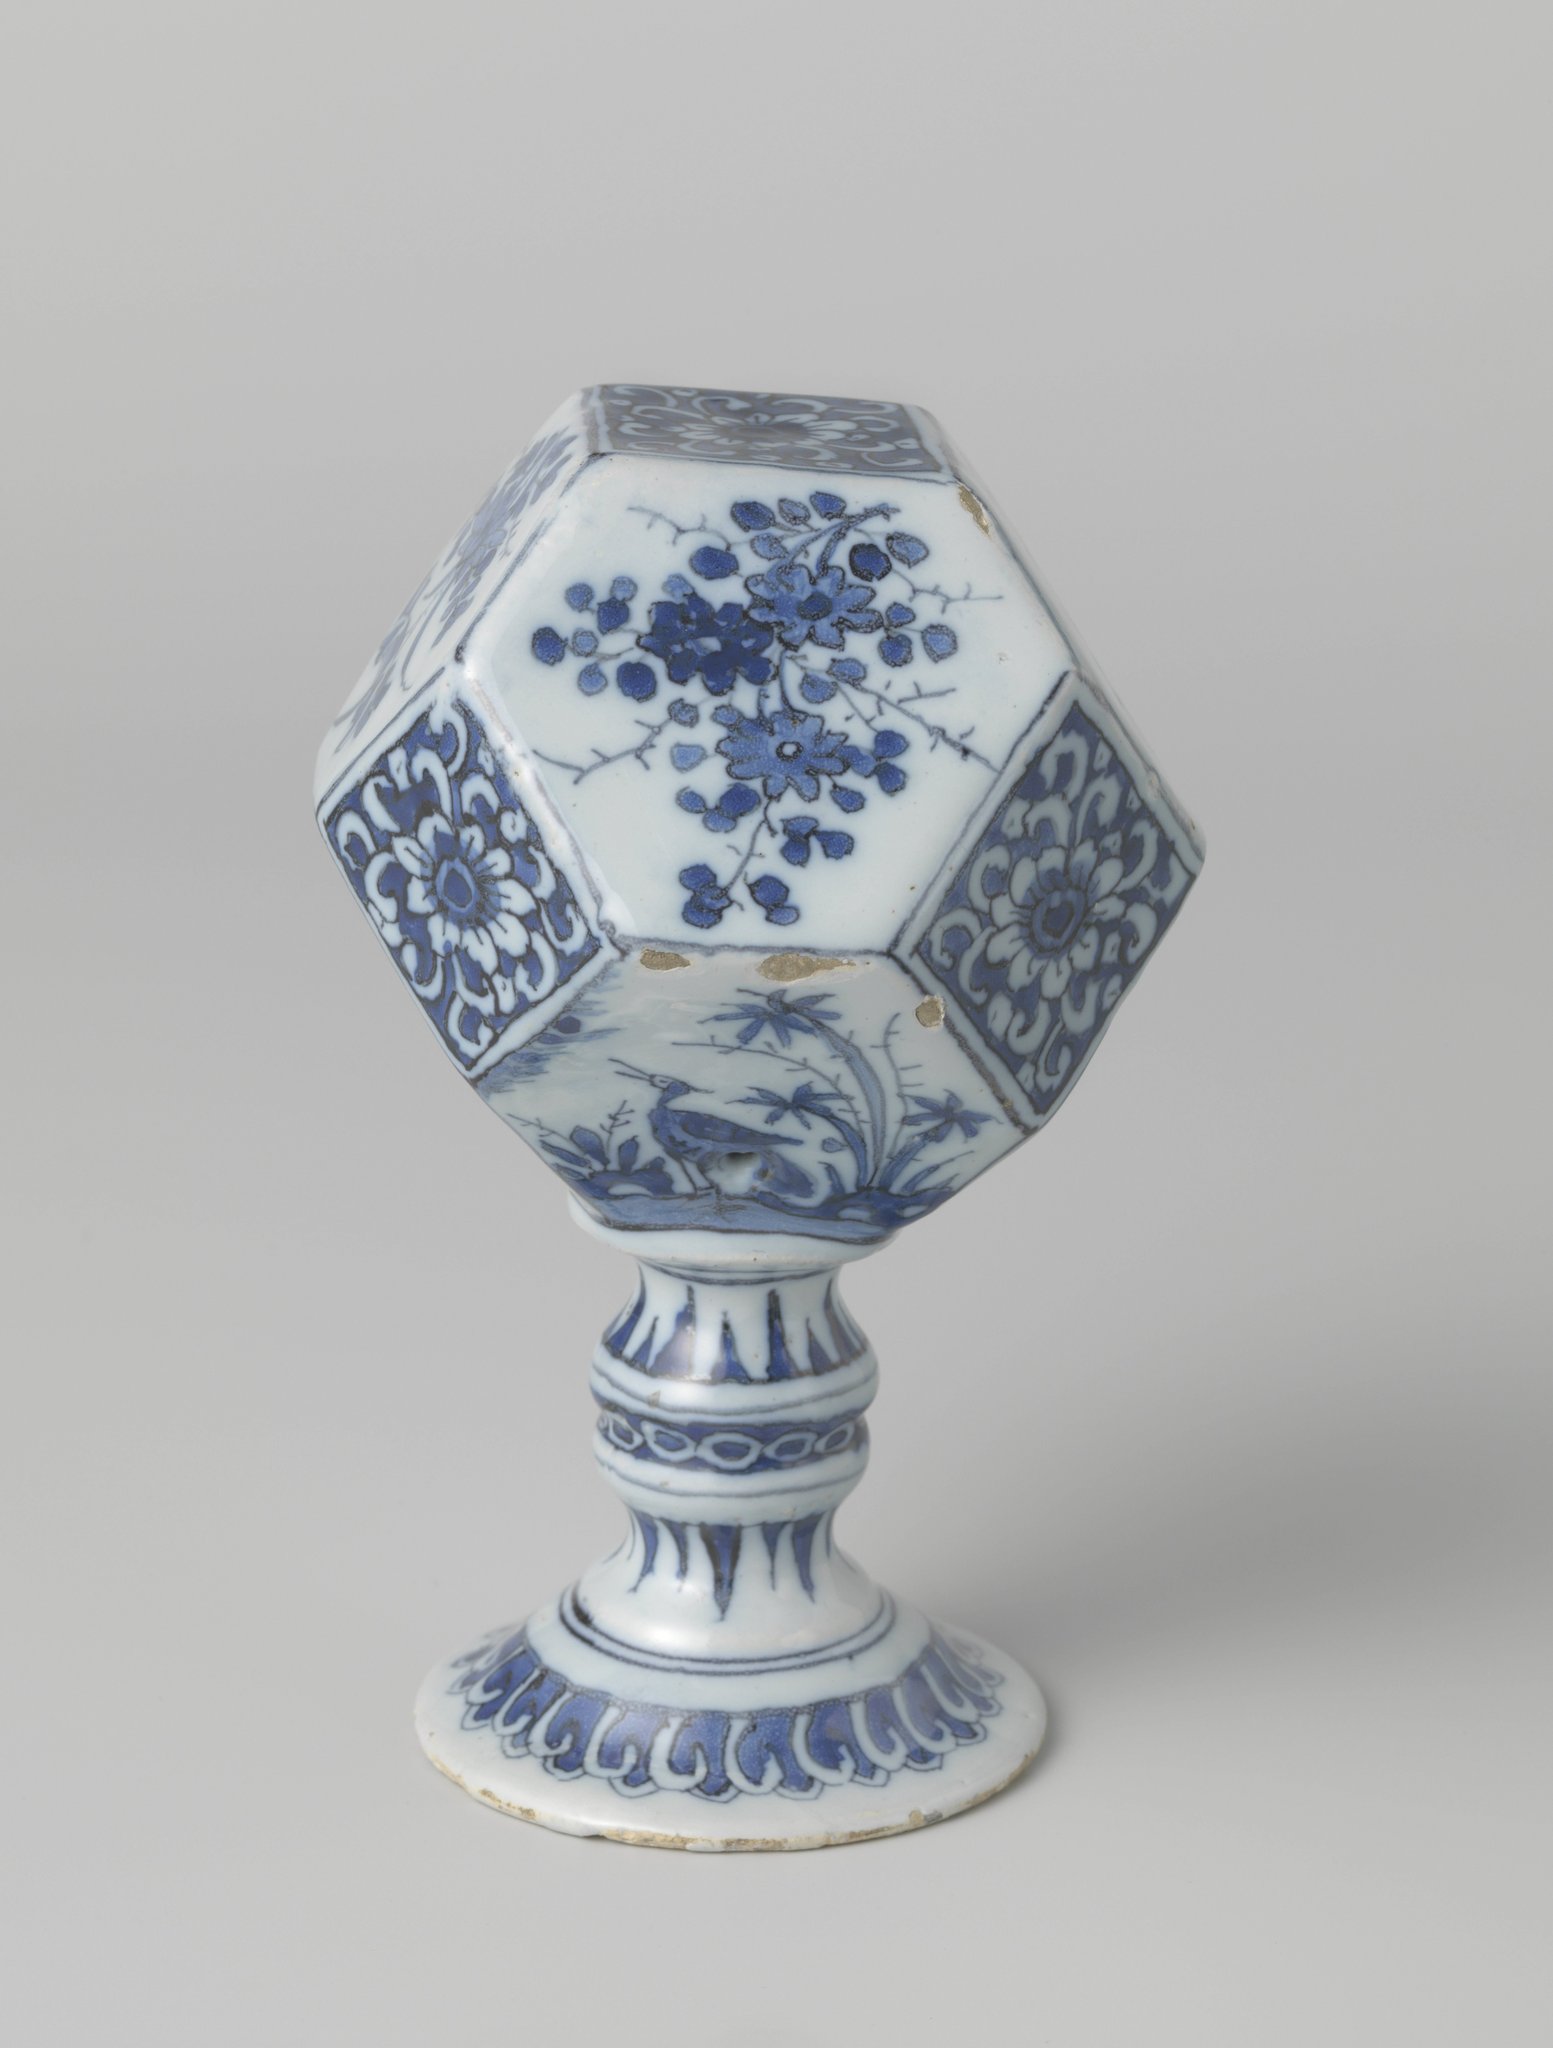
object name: decoratief object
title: Decorative object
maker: adrianus kocx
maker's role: plateelbakker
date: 1685-1690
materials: faience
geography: delft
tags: flowers ~ ornament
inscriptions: mark: ‘6/ AK (ineen)/ 3’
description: Decoratief object van faience met op het Chinese porselein geïnspireerde bloemen.